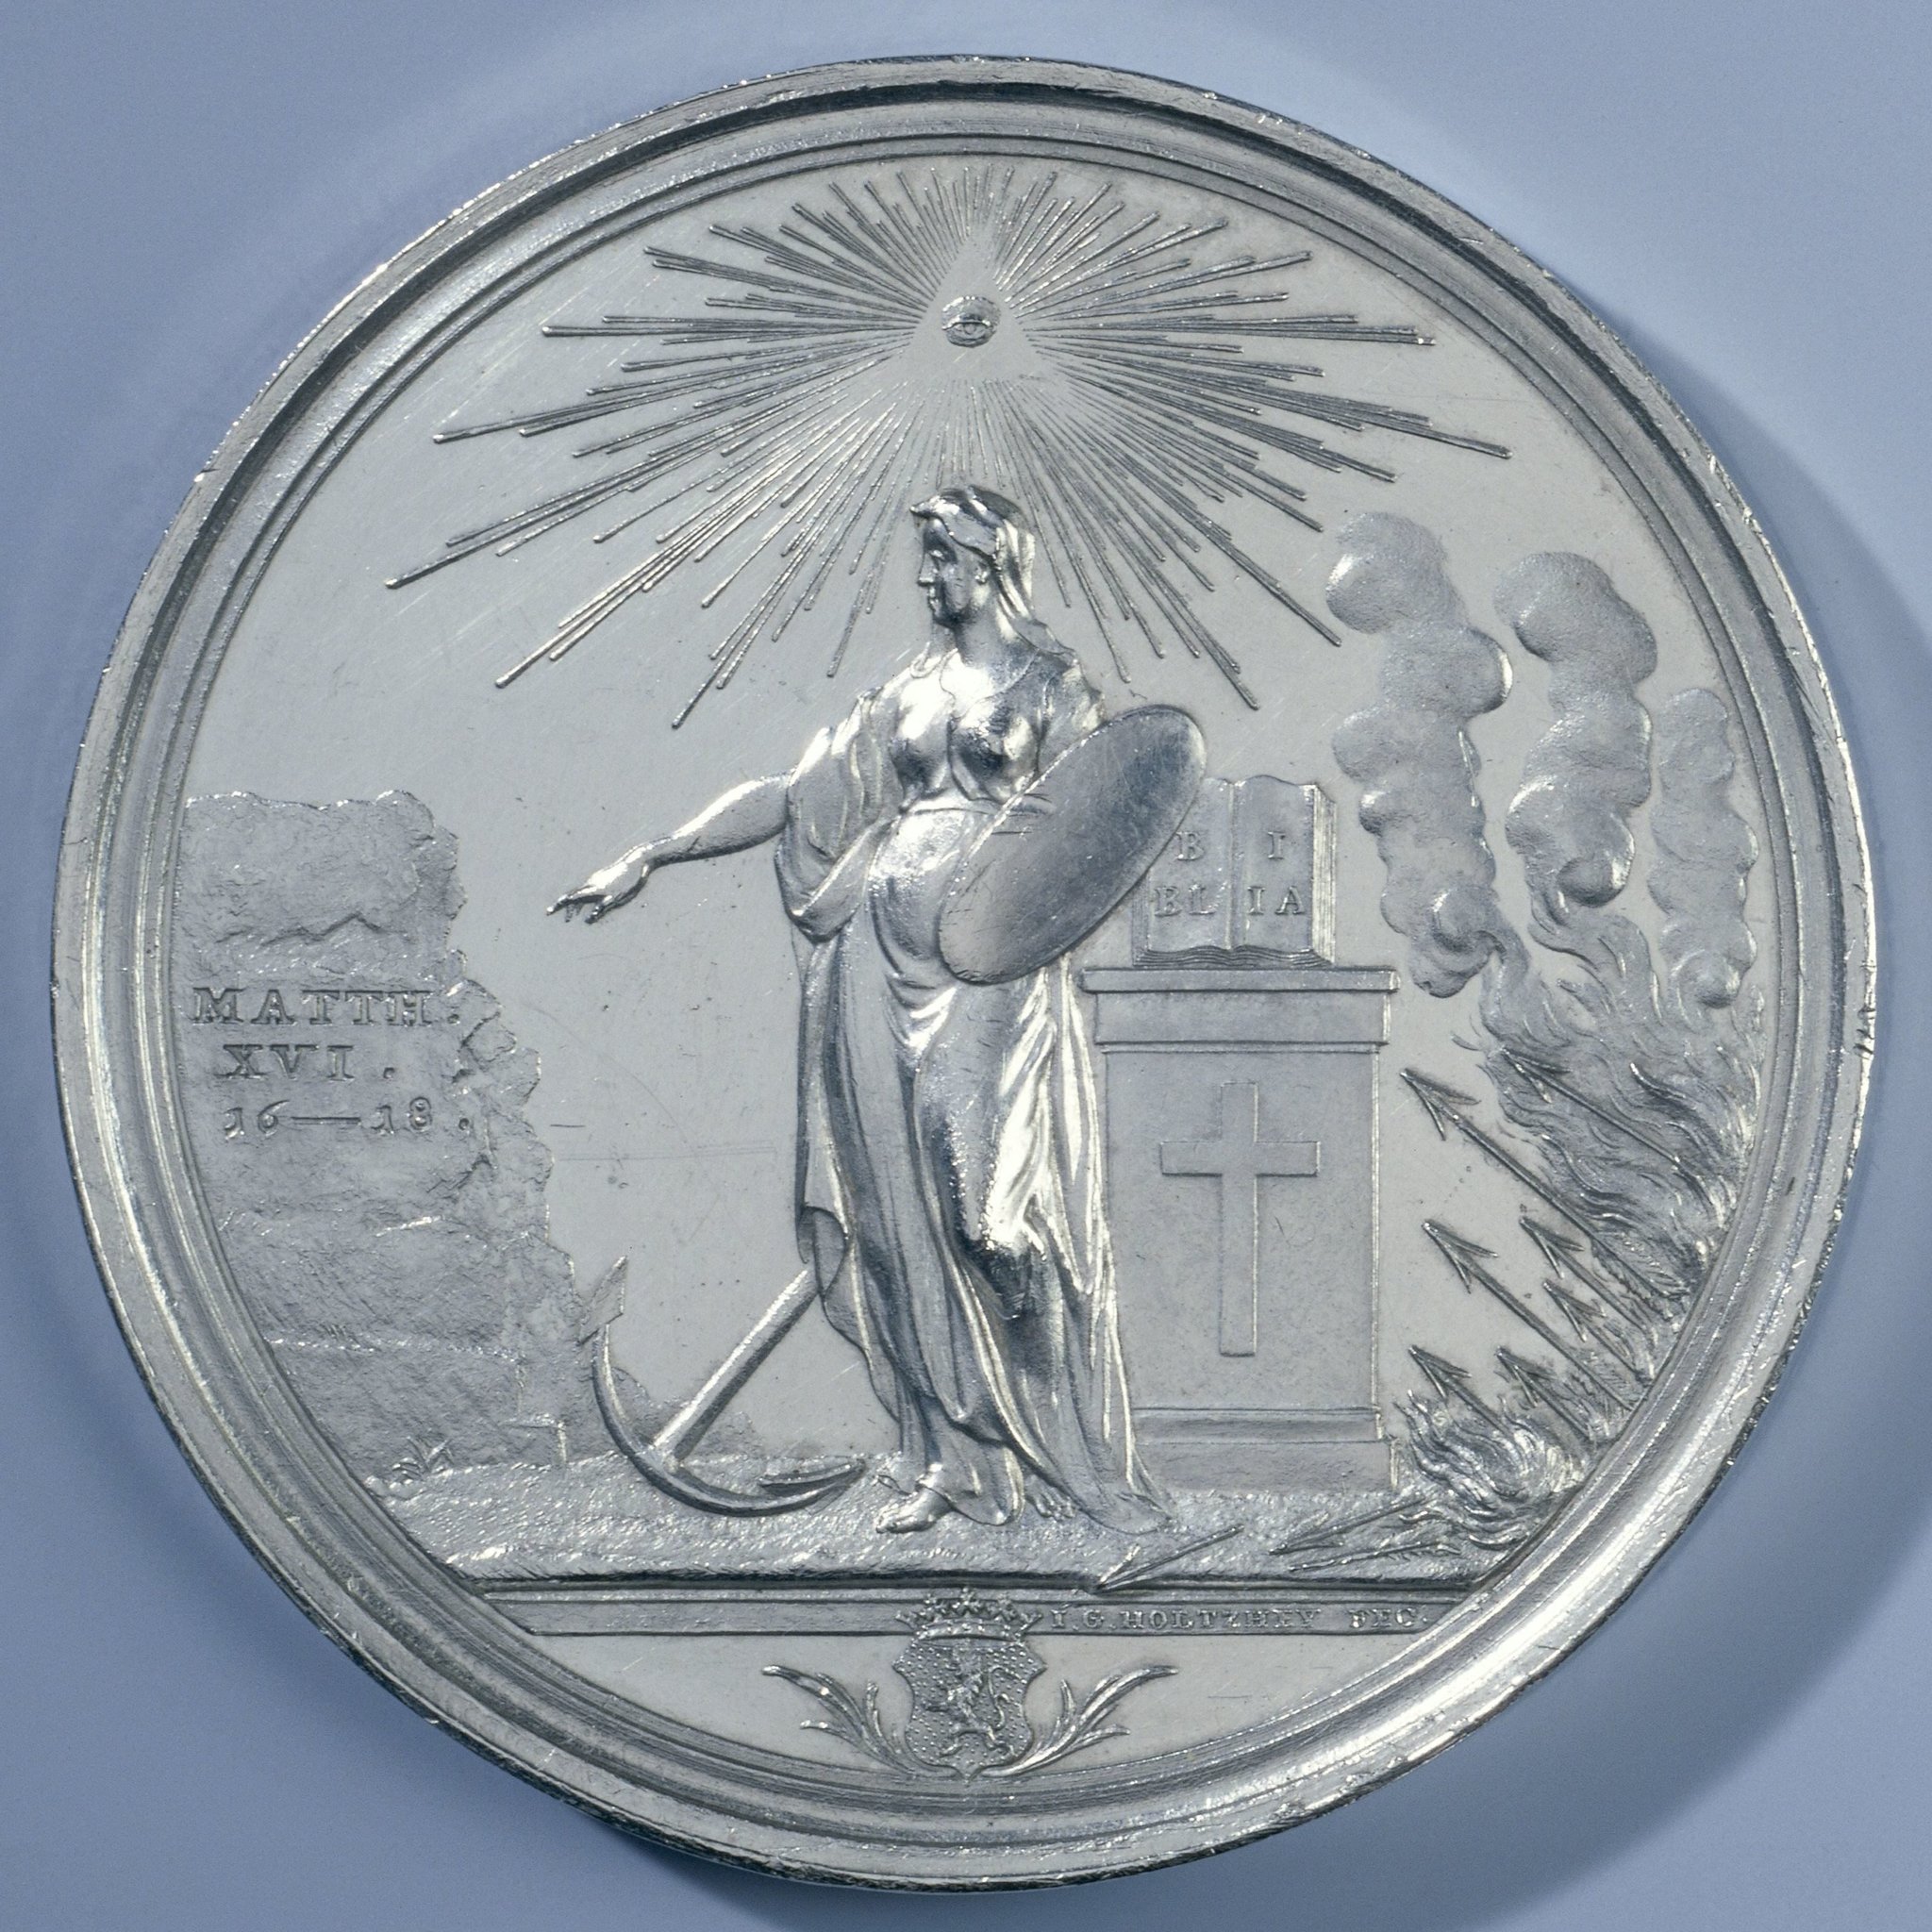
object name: medal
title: Genootschap tot verdediging van den Christelijken Godsdienst, penning toegekend aan Allard Hulshoff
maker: johan george holtzhey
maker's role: mintmaster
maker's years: 1726-1808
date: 1791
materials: silver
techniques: engraving, striking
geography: amsterdam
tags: the hague, amsterdam